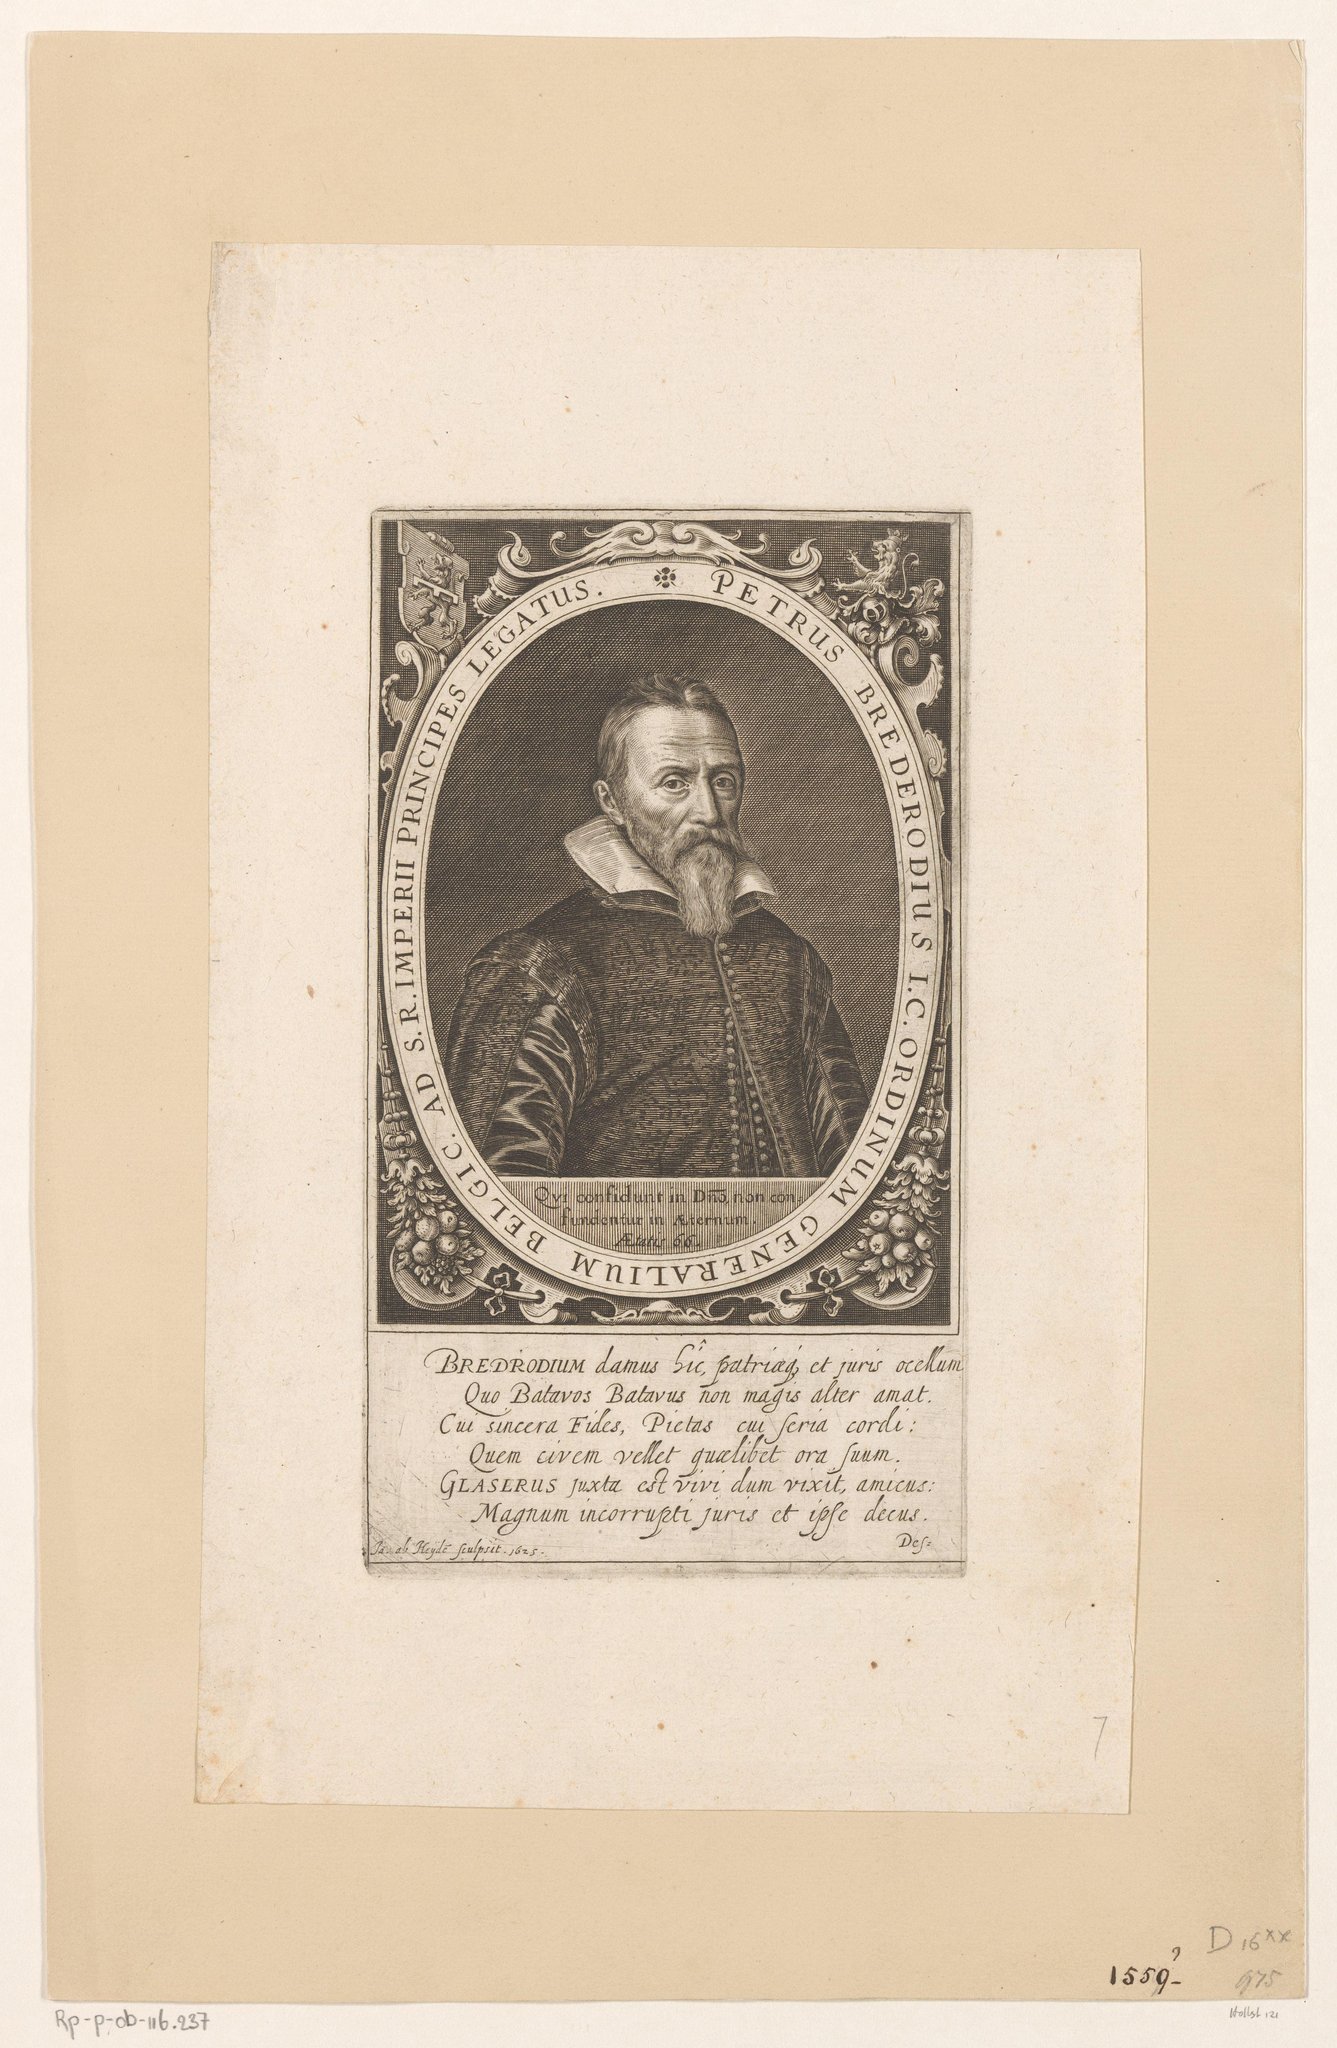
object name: print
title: Portret van Pieter Cornelis van Brederode op 66-jarige leeftijd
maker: jacob van der heyden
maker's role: draughtsman, print maker, publisher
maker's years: 1573-1645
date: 1625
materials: paper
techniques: engraving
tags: the hague, historical persons, ornament ~ cartouche, armorial bearing, heraldry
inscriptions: date